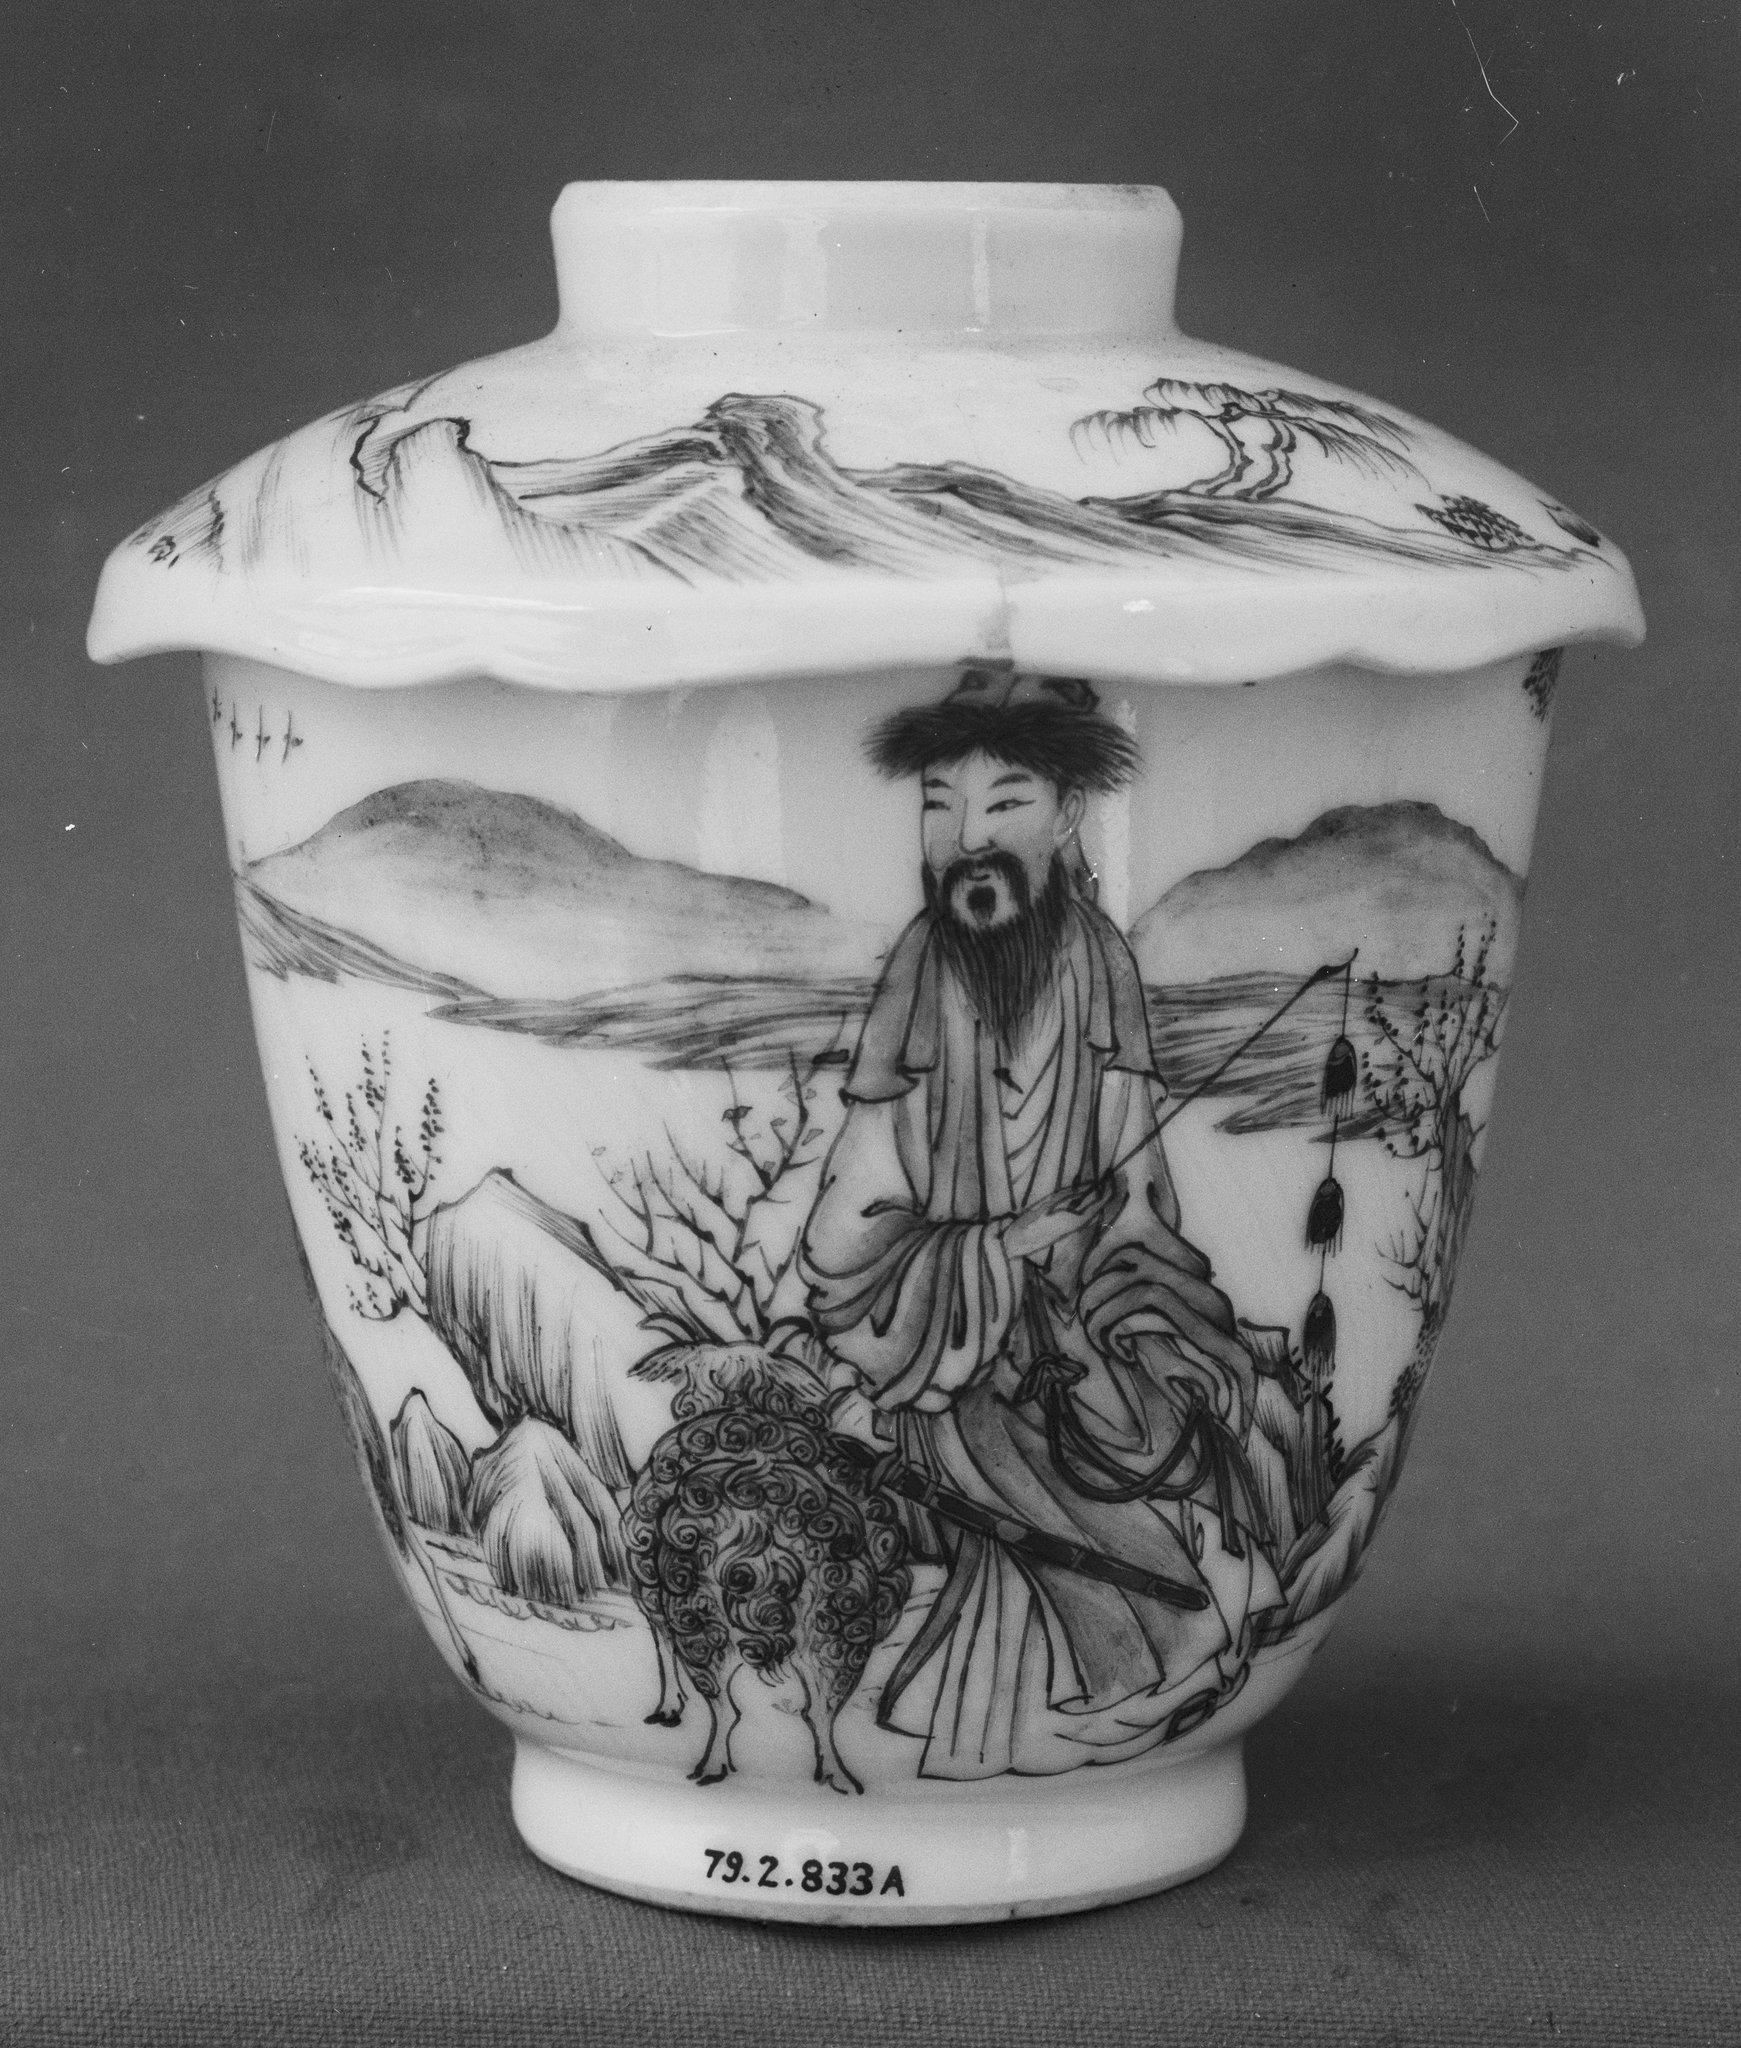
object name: covered cup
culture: chinese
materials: gilt, porcelain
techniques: overglaze, painting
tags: men,sheep